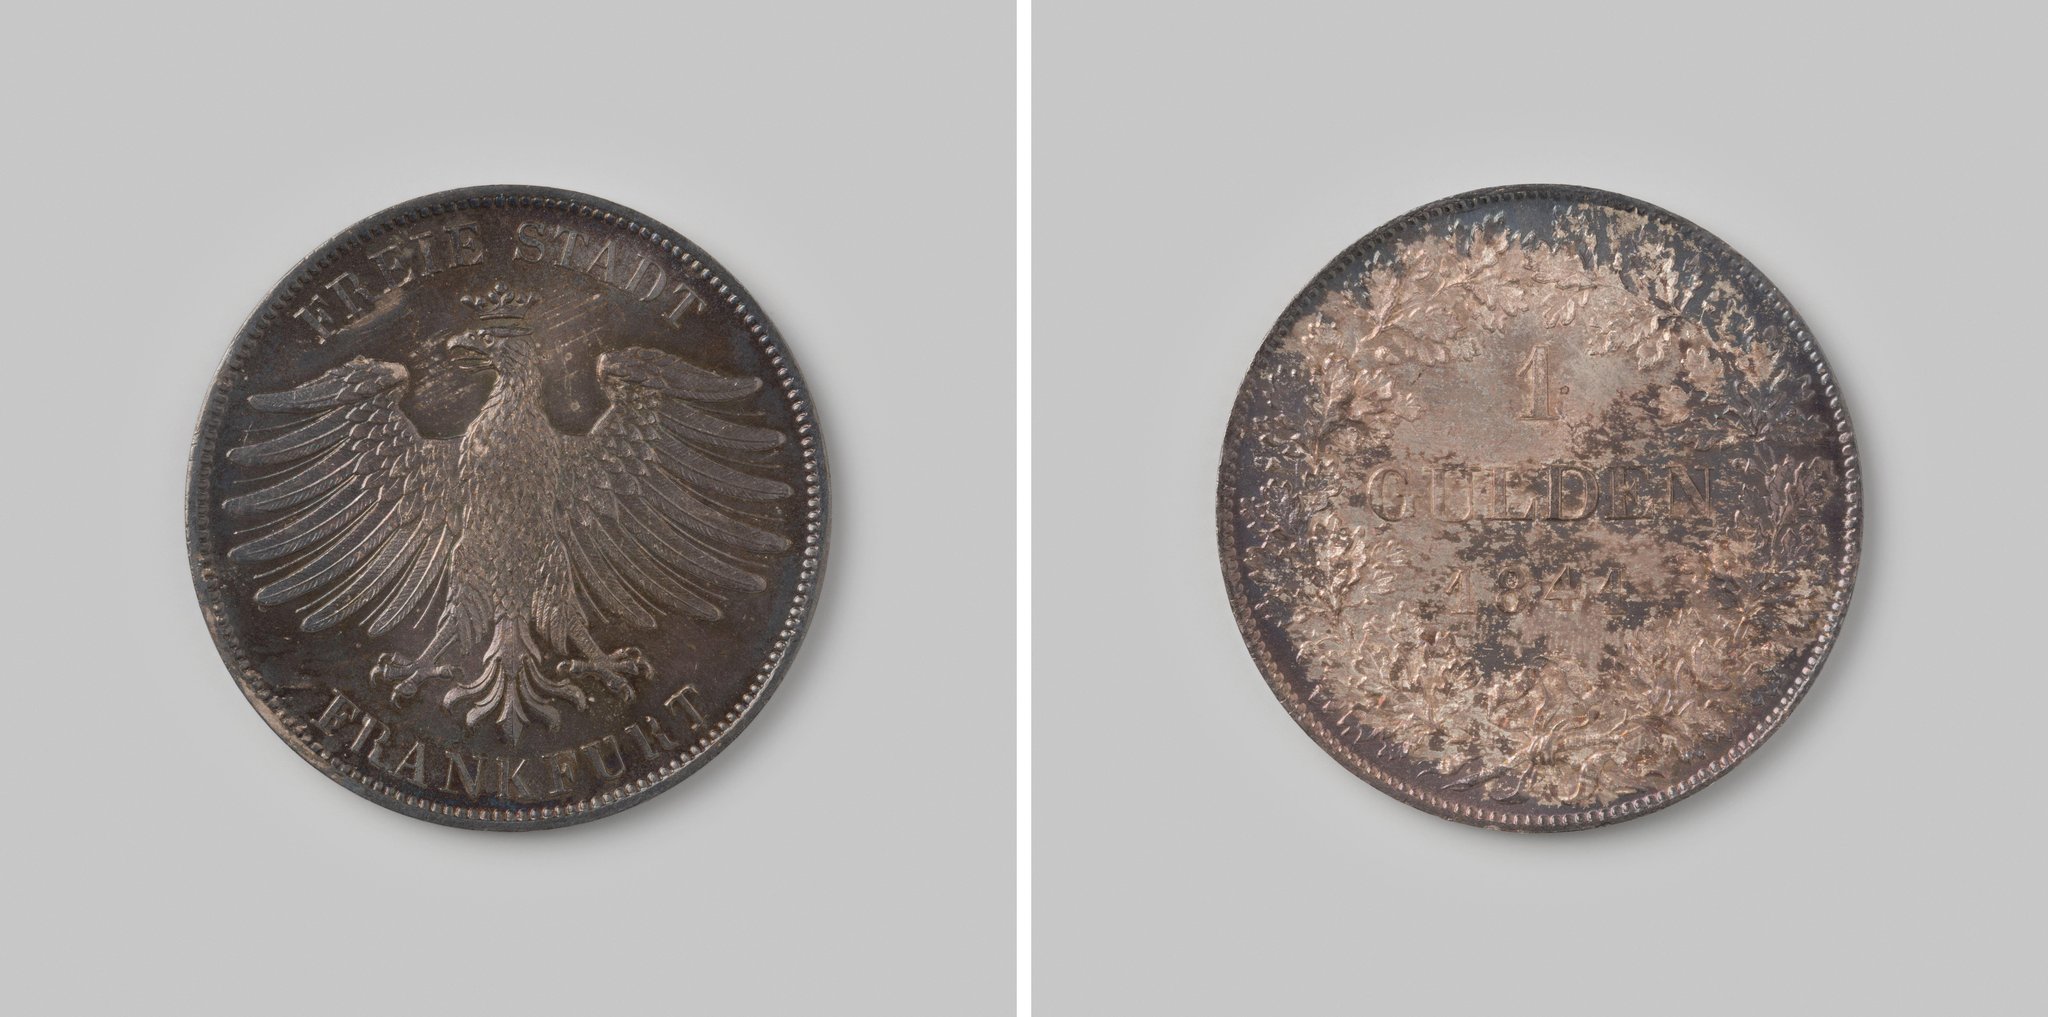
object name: coin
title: Gulden van de vrije rijksstad Frankfurt am Main, 1841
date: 1841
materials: silver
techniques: striking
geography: frankfurt am main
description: Zilveren munt. Voorzijde: gekroonde enkelkoppige adelaar. Keerzijde: binnen twee samengebonden eiketakken in twee regels waarde-aanduiding, waaronder jaartal. Randschrift.